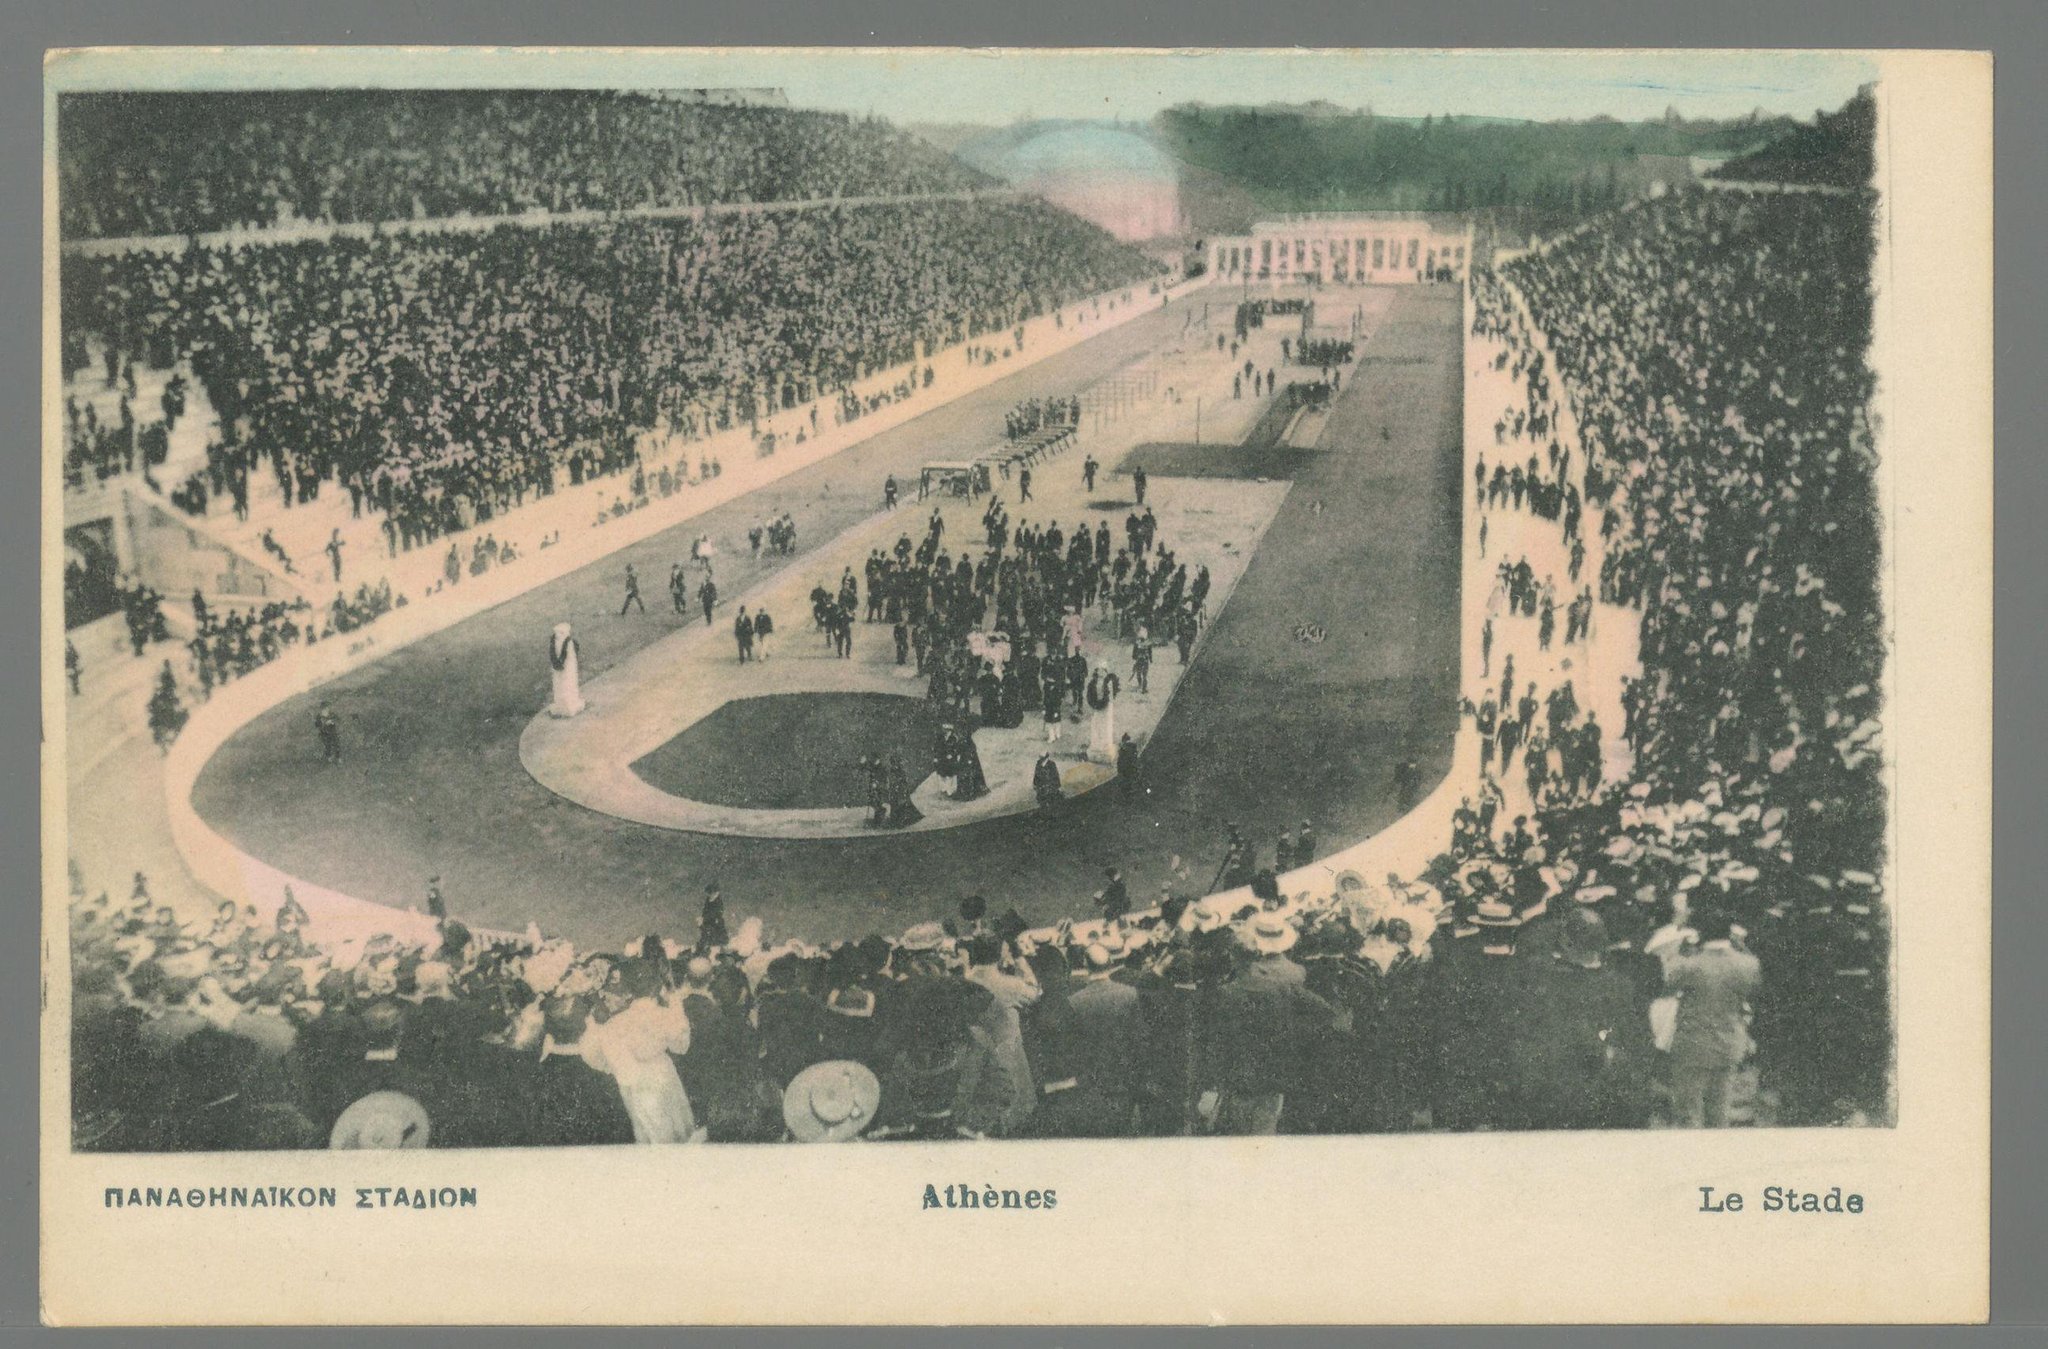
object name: ansichtkaart, prentbriefkaart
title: Athènes. Le Stade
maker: Anonymous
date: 1906-1930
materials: cardboard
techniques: photograph, hand coloring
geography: athens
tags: running, race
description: Voor de Franse titel staat de titel in het Grieks.